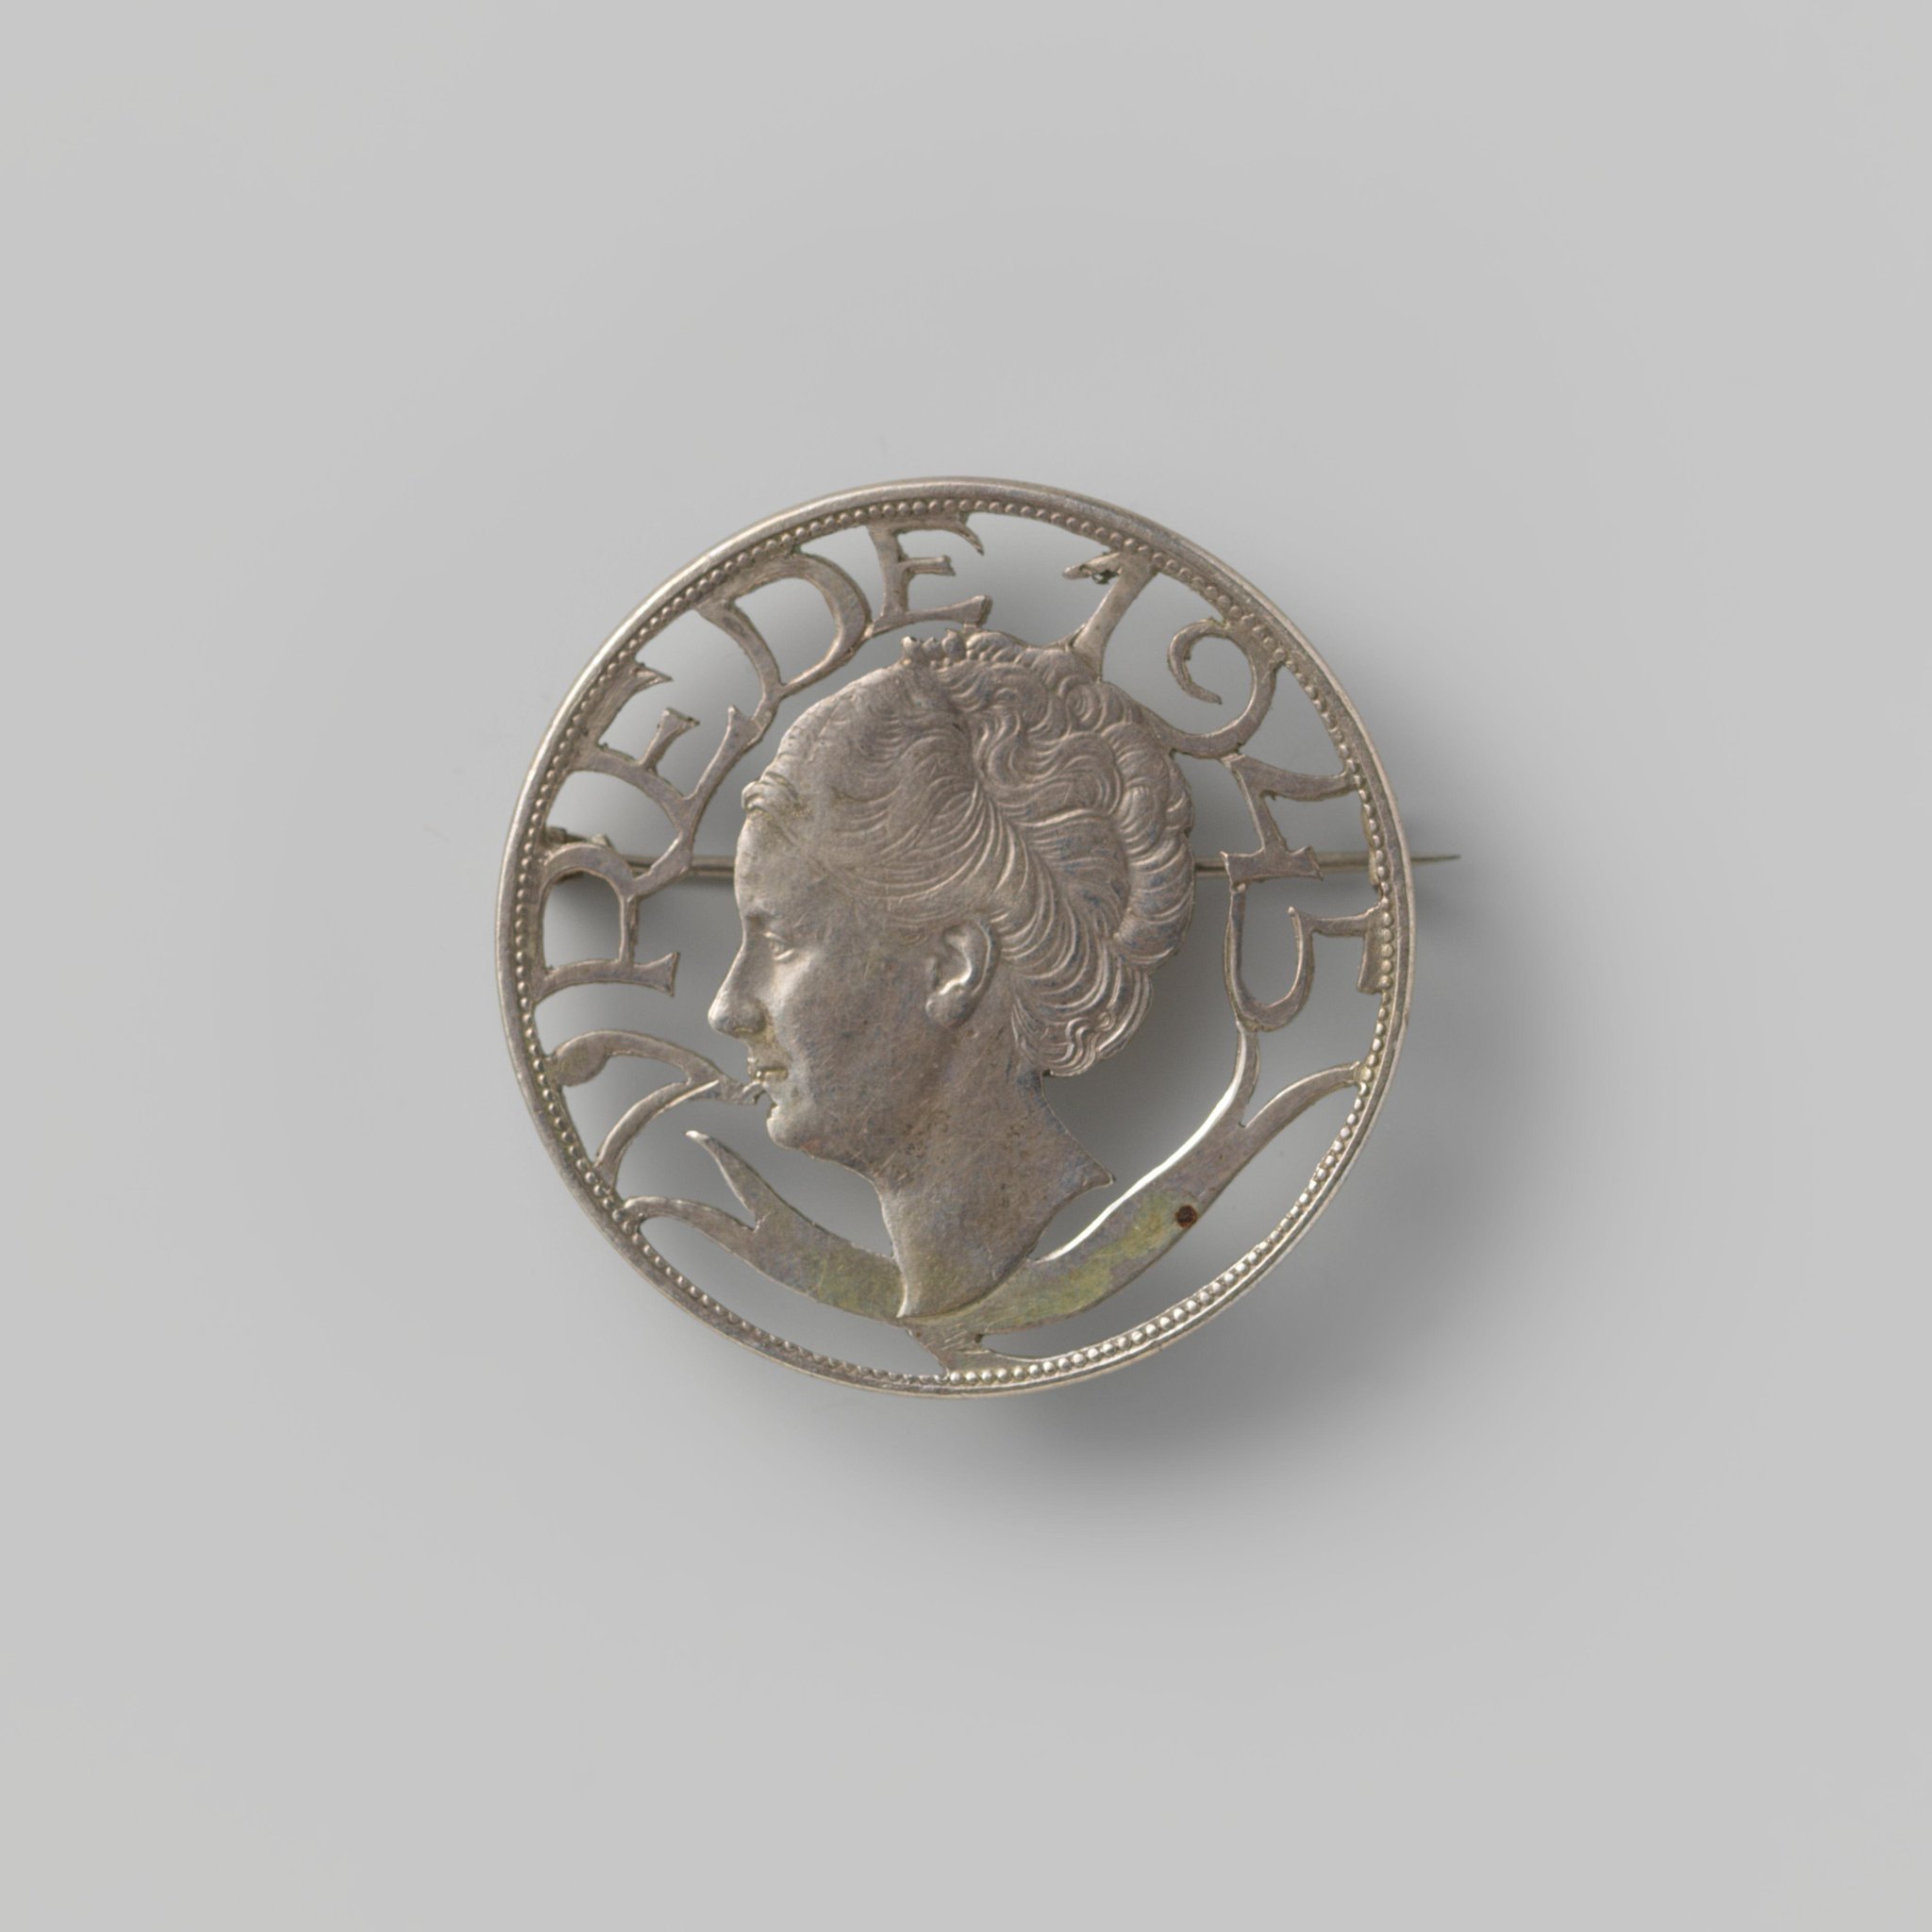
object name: brooch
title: Miscellaneous brooches and coin jewels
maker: Anonymous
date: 1945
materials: silver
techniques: sawing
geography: netherlands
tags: wilhelmina of the netherlands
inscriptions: : ‘VREDE 1945’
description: Silent Resistance –War and Liberation Jewellery During the Second World War, small pieces of jewellery were worn in the Netherlands as a silent protest against the German occupier. In April 1941, Dutch coins were officially confiscated for the war industry. As jewellery did not have to be surrendered, coins were quickly transformed into rings, brooches, pins and bracelets. A portrait of Queen Wilhelmina was worn as a sign of resistance, as well as a token of loyalty to the royal family. Margriet Francisca, the third daughter of Princess Juliana and Prince Bernard, was born in Canada in January 1943. The pin with the three yellow chicks refers to the three young princesses Beatrix, Irene and Margriet and the steadfastness of the Dutch royal family. After the liberation, coins and silver were used for jewellery conveying messages of hope for a peaceful future.